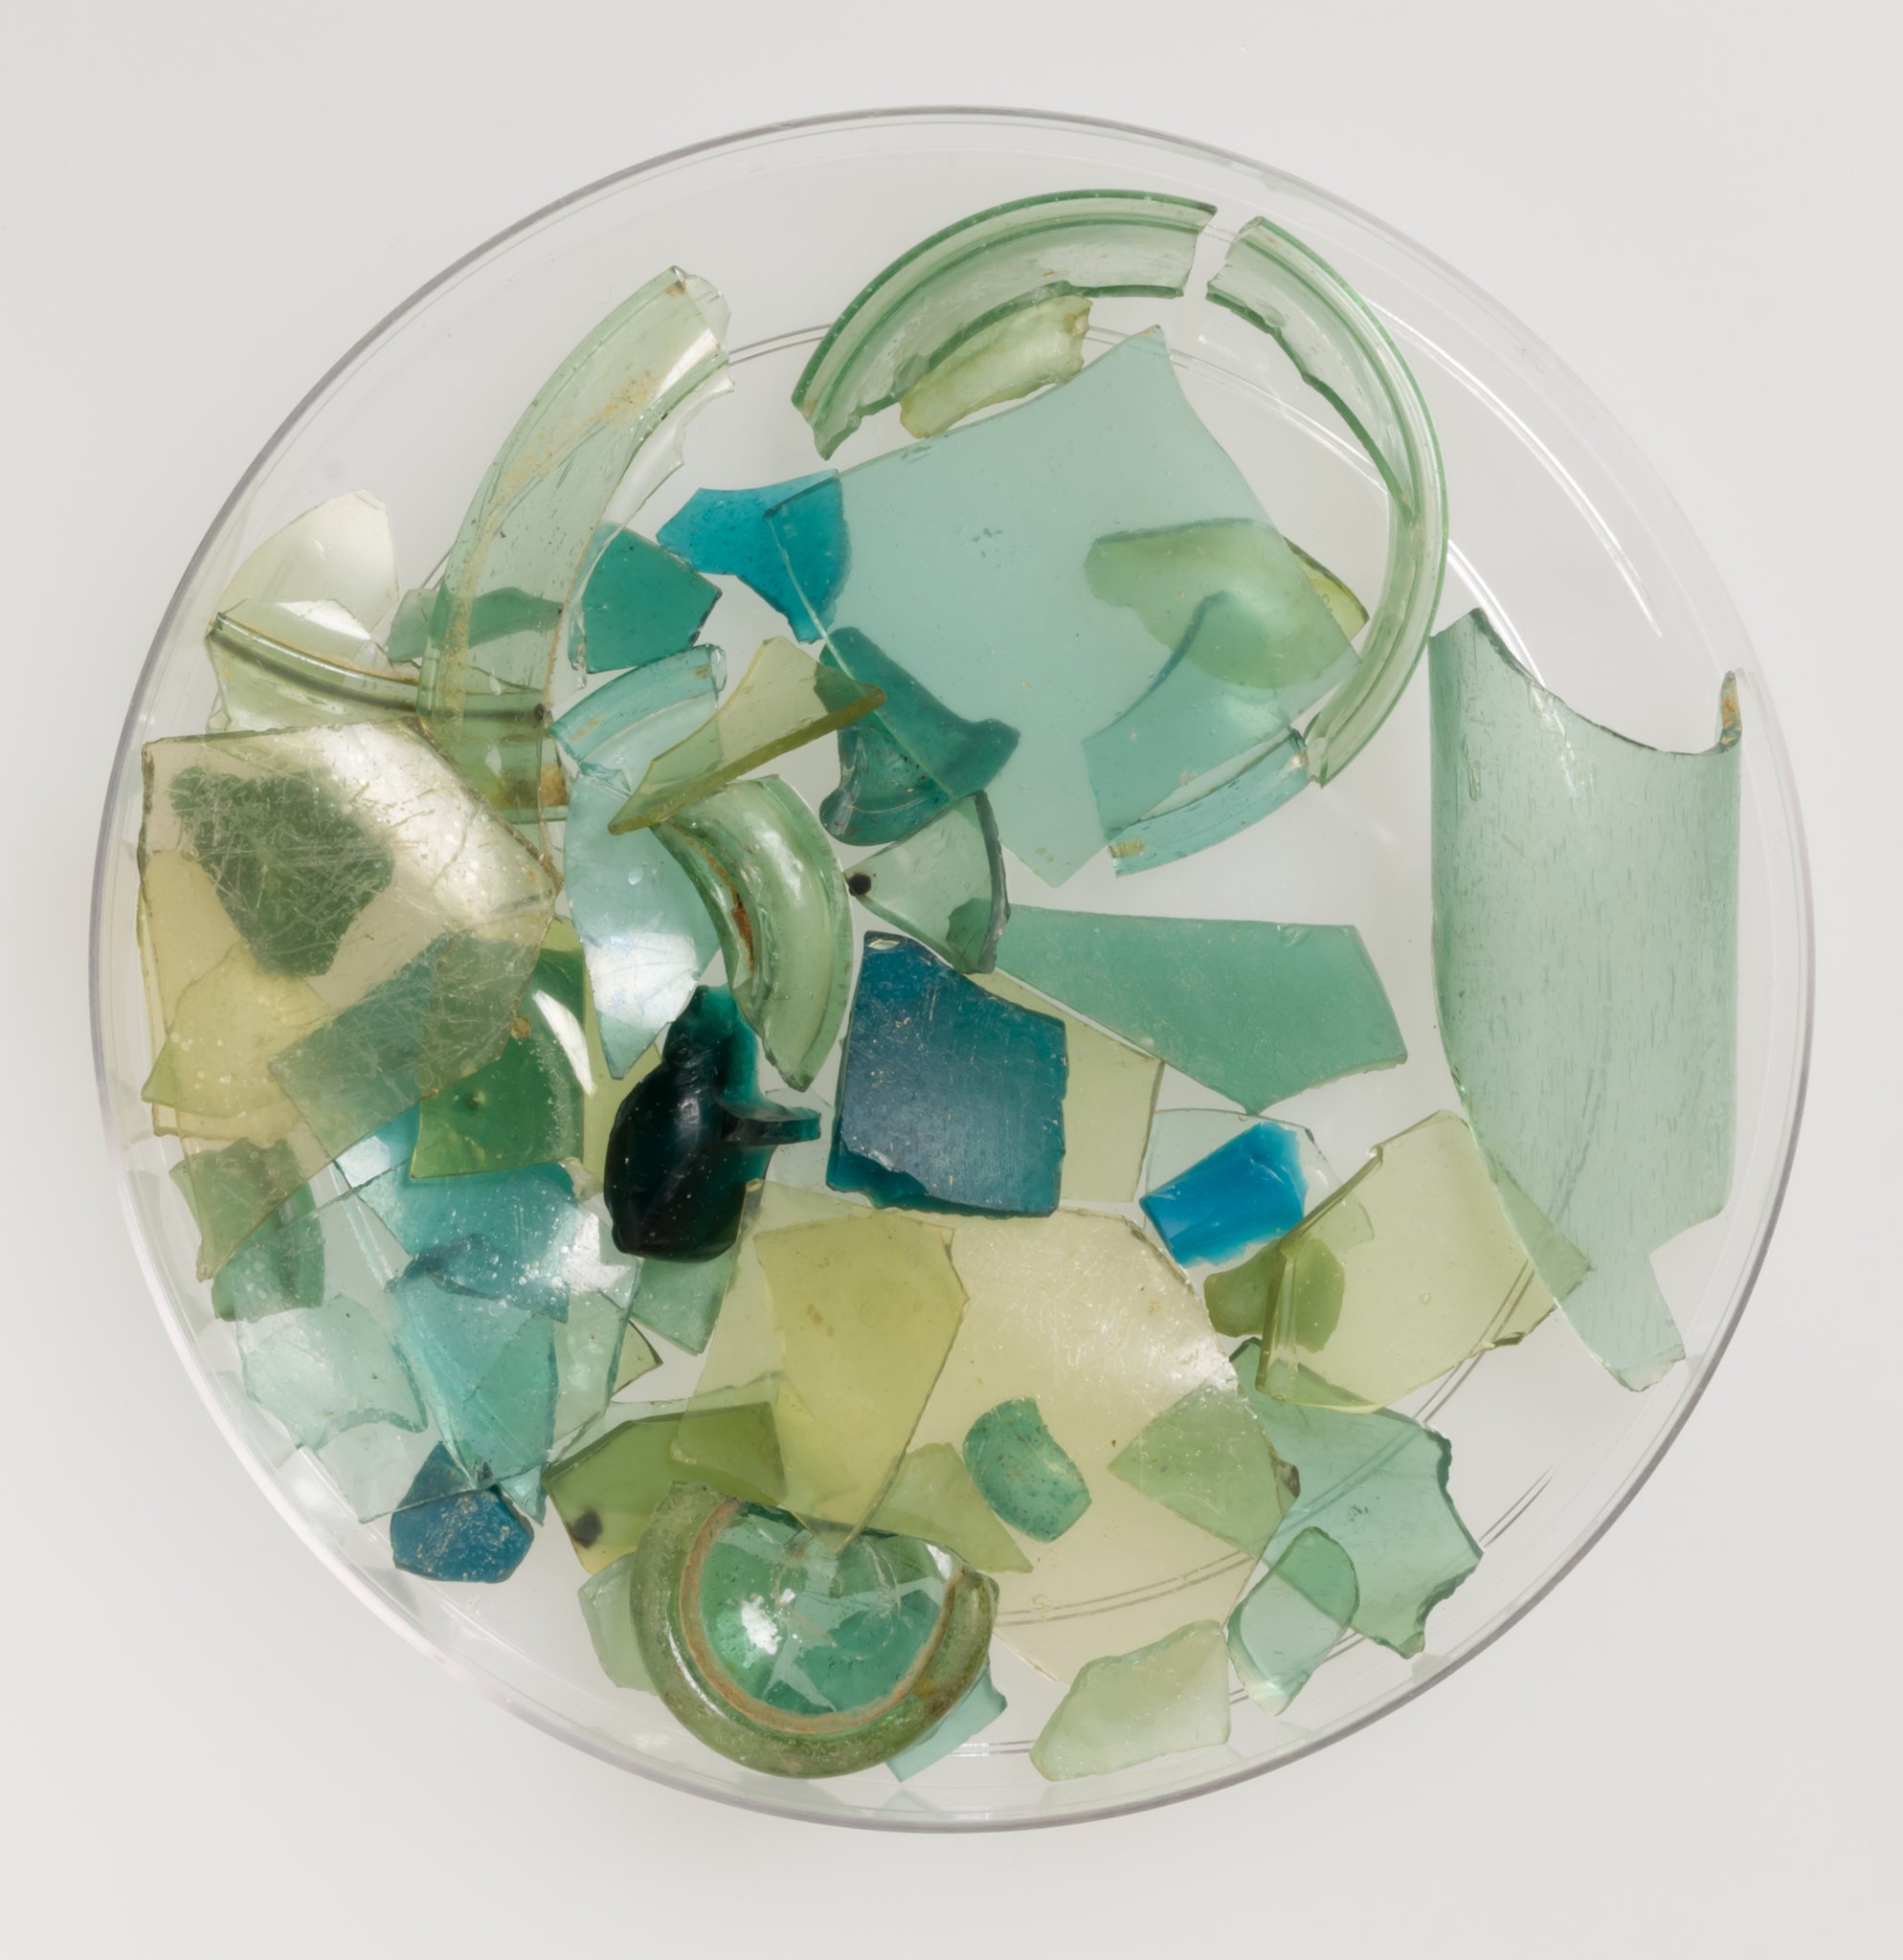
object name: glass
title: Glass Fragments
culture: coptic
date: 301-700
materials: glass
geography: egypt